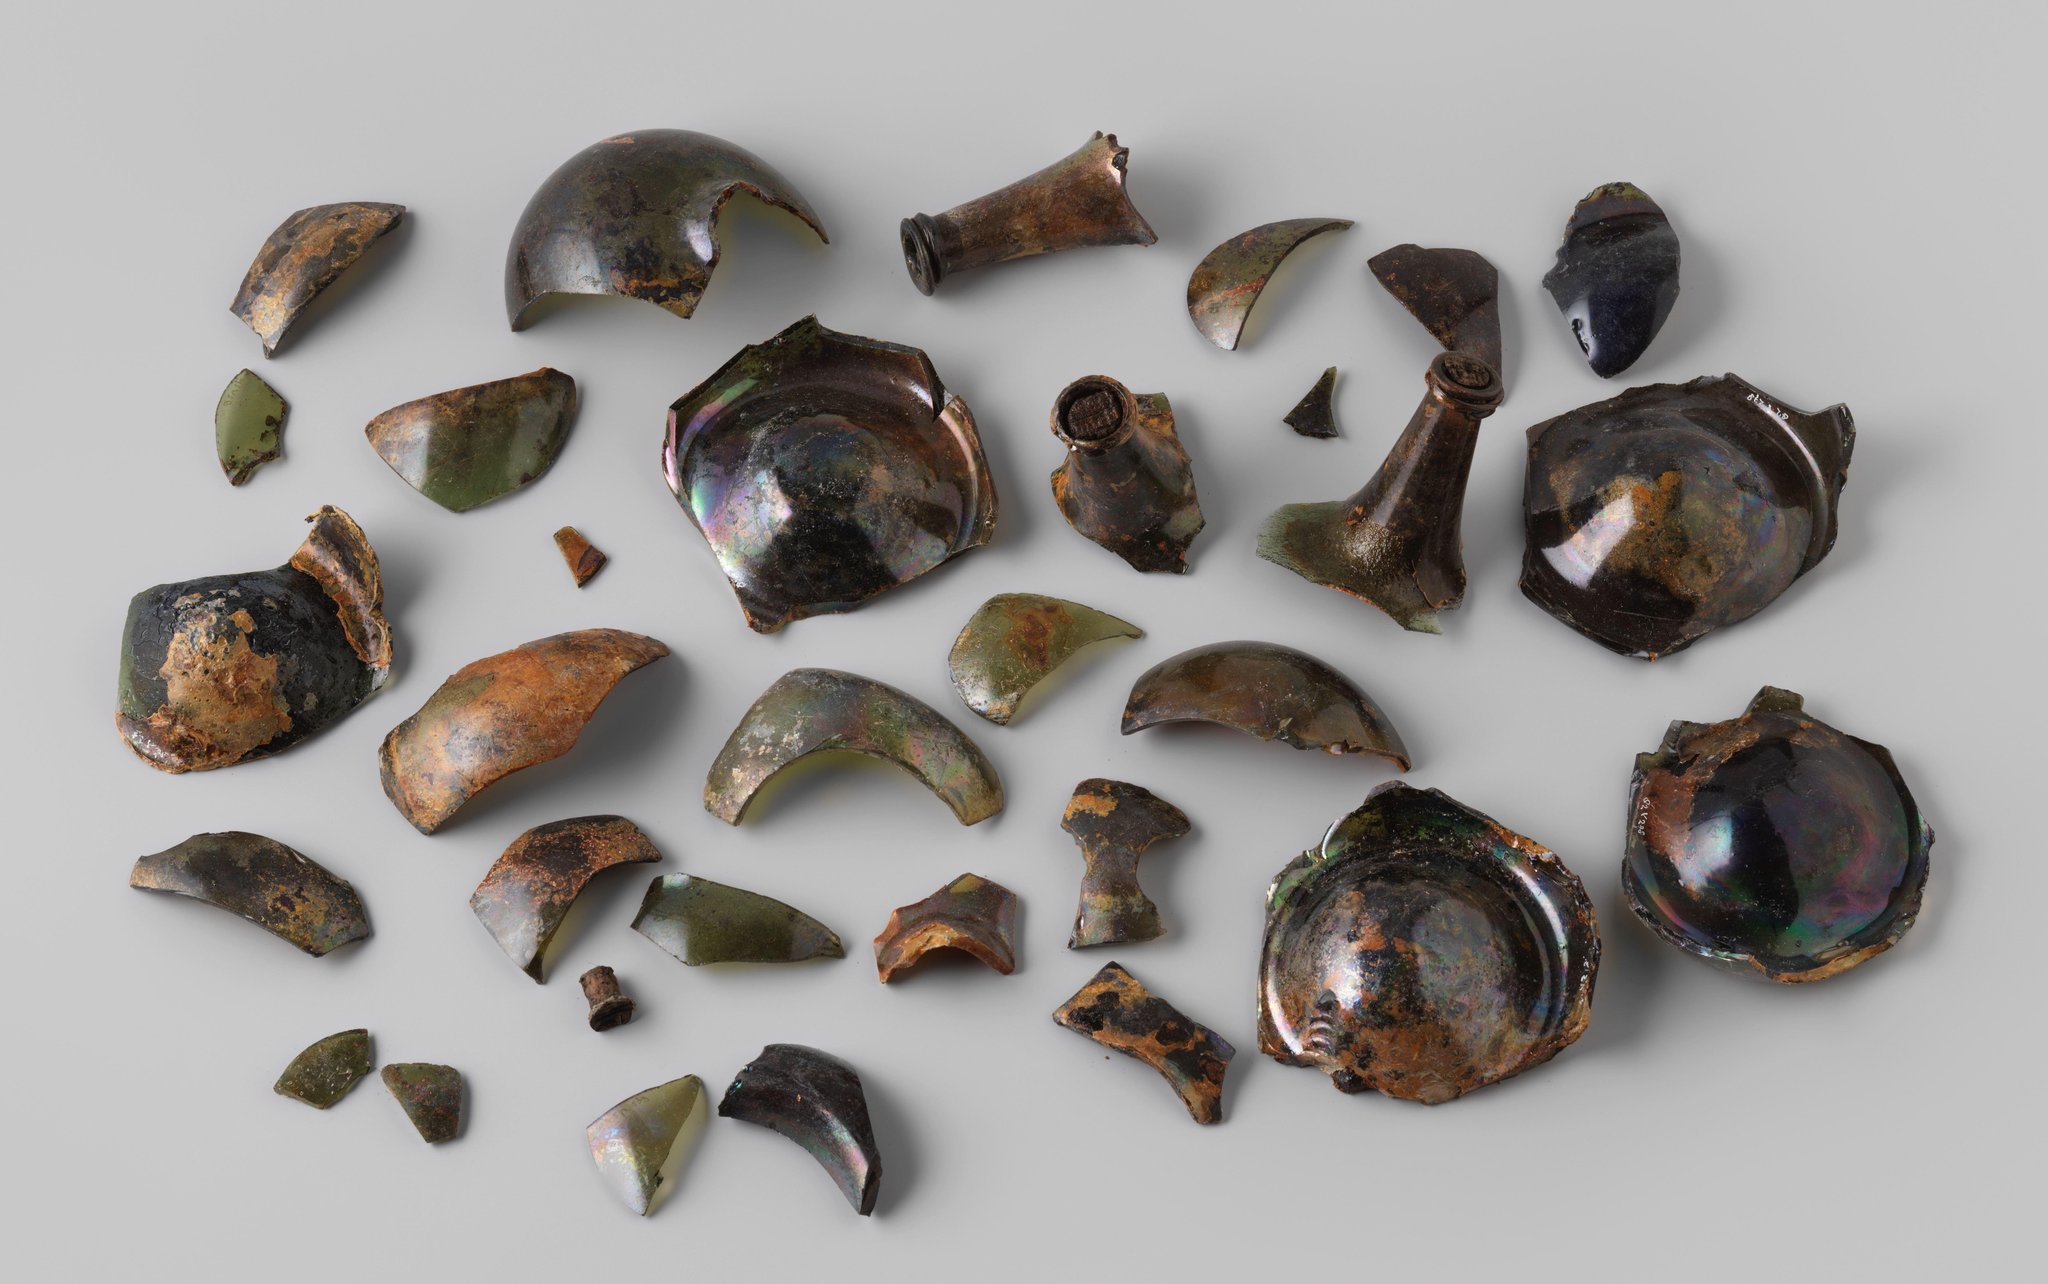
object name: wine bottle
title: Scherven van wijnflessen uit het wrak van de Oost-Indiëvaarder 't Vliegend Hart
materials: cork, glass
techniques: green glass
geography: netherlands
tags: 't vliegend hart (schip), verenigde oostindische compagnie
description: Scherven van uivormige wijnflessen van groen glas waar rode (port)wijn in heeft gezeten. Enkele halzen met kurk. Eén hals met lak.